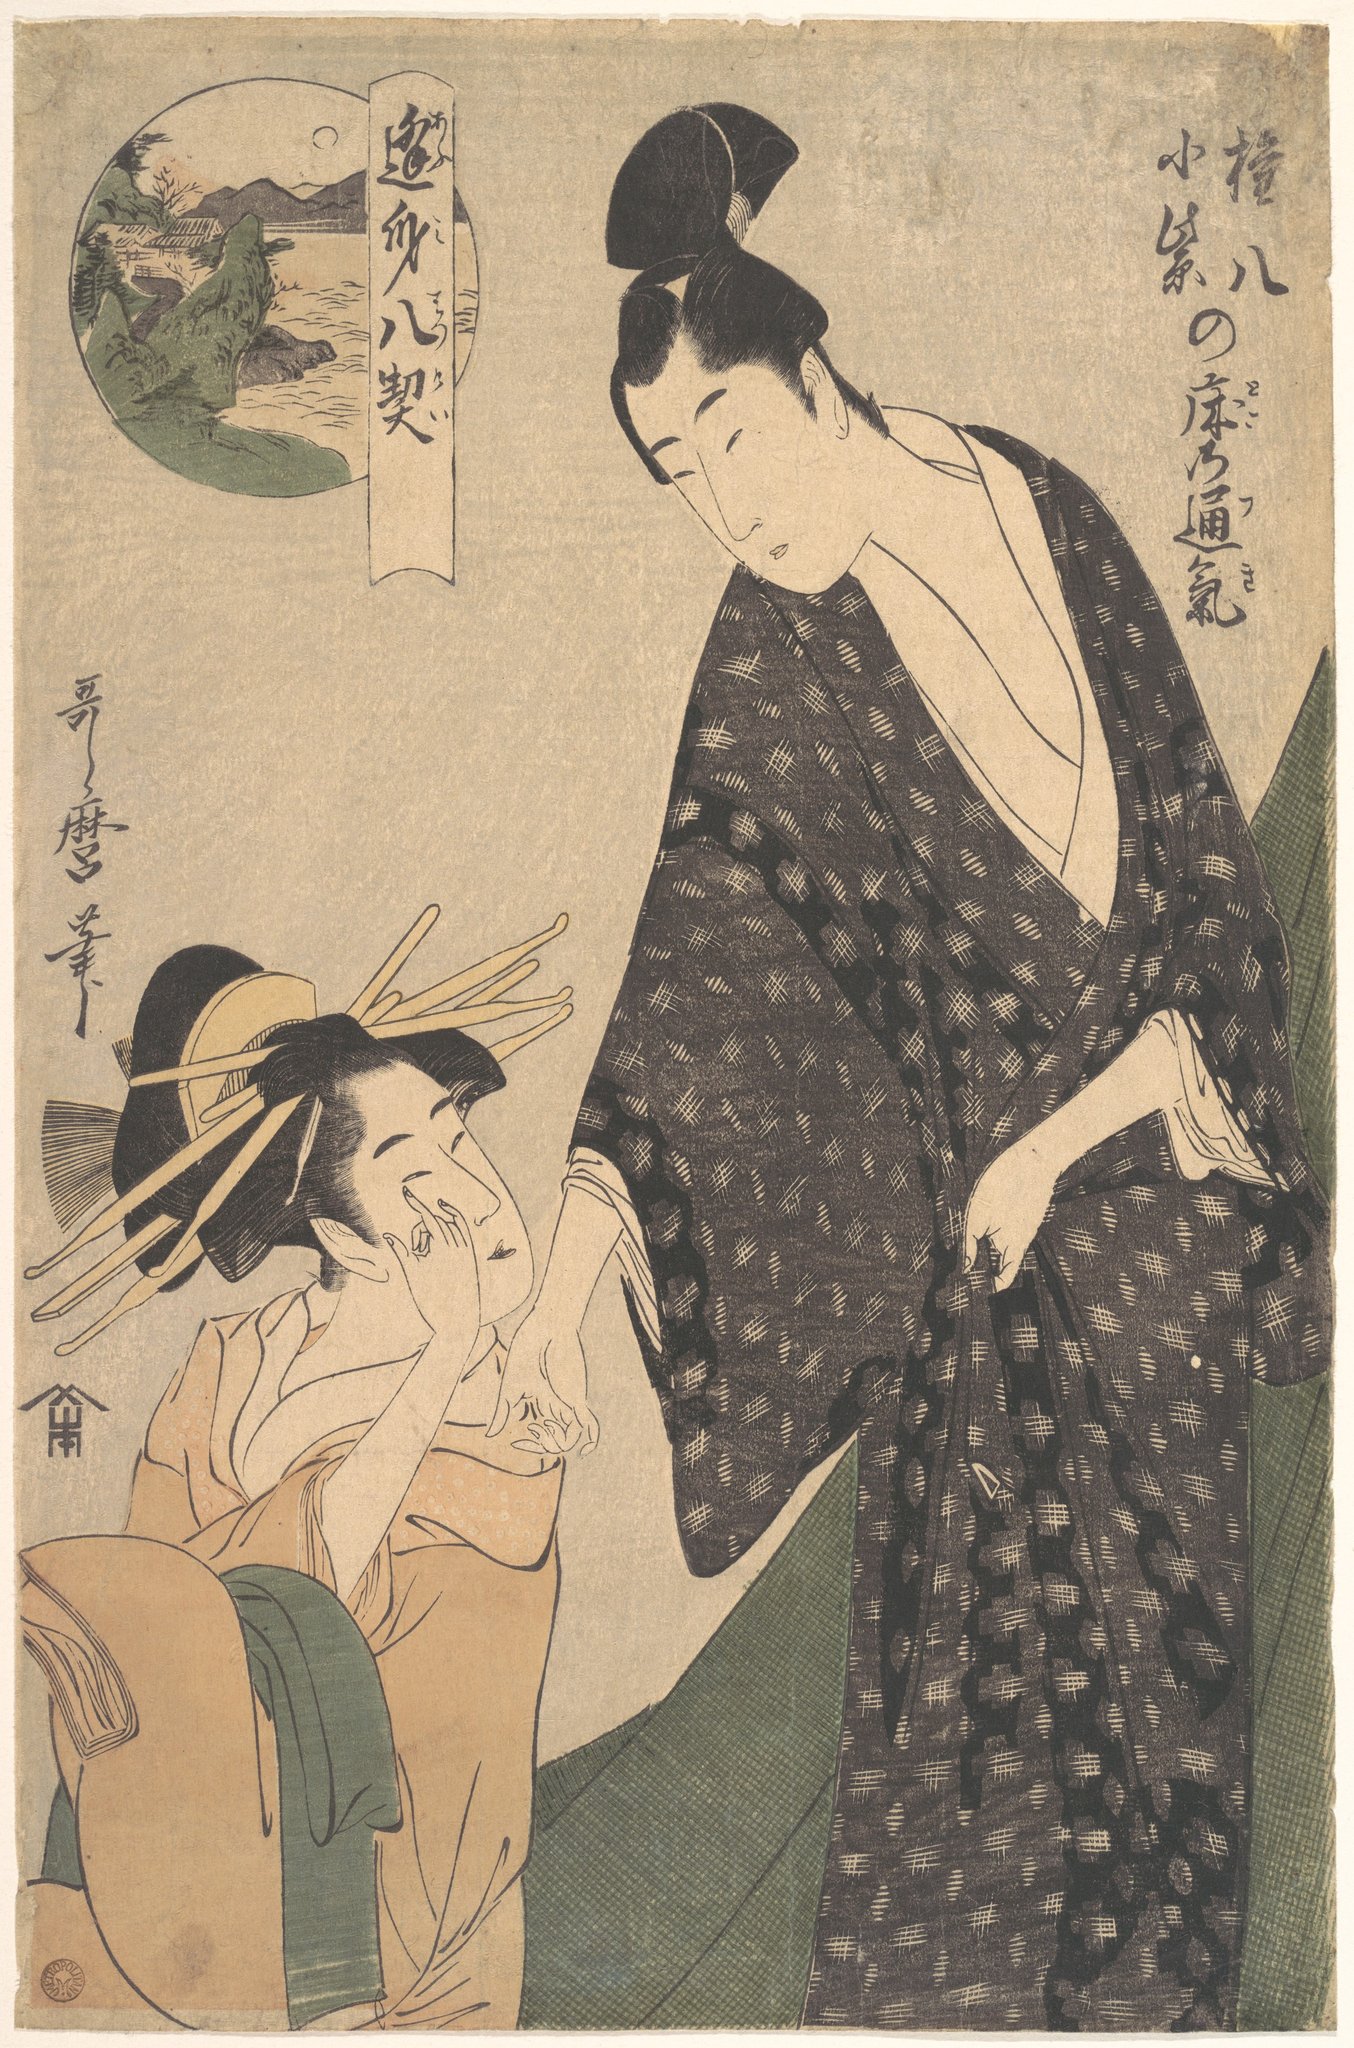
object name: print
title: Gonpachi ni Komurasaki no Toko no Tsuki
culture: japanese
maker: kitagawa utamaro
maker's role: artist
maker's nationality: japanese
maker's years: 1754-1806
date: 1795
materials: ink, paper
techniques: woodblock print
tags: women